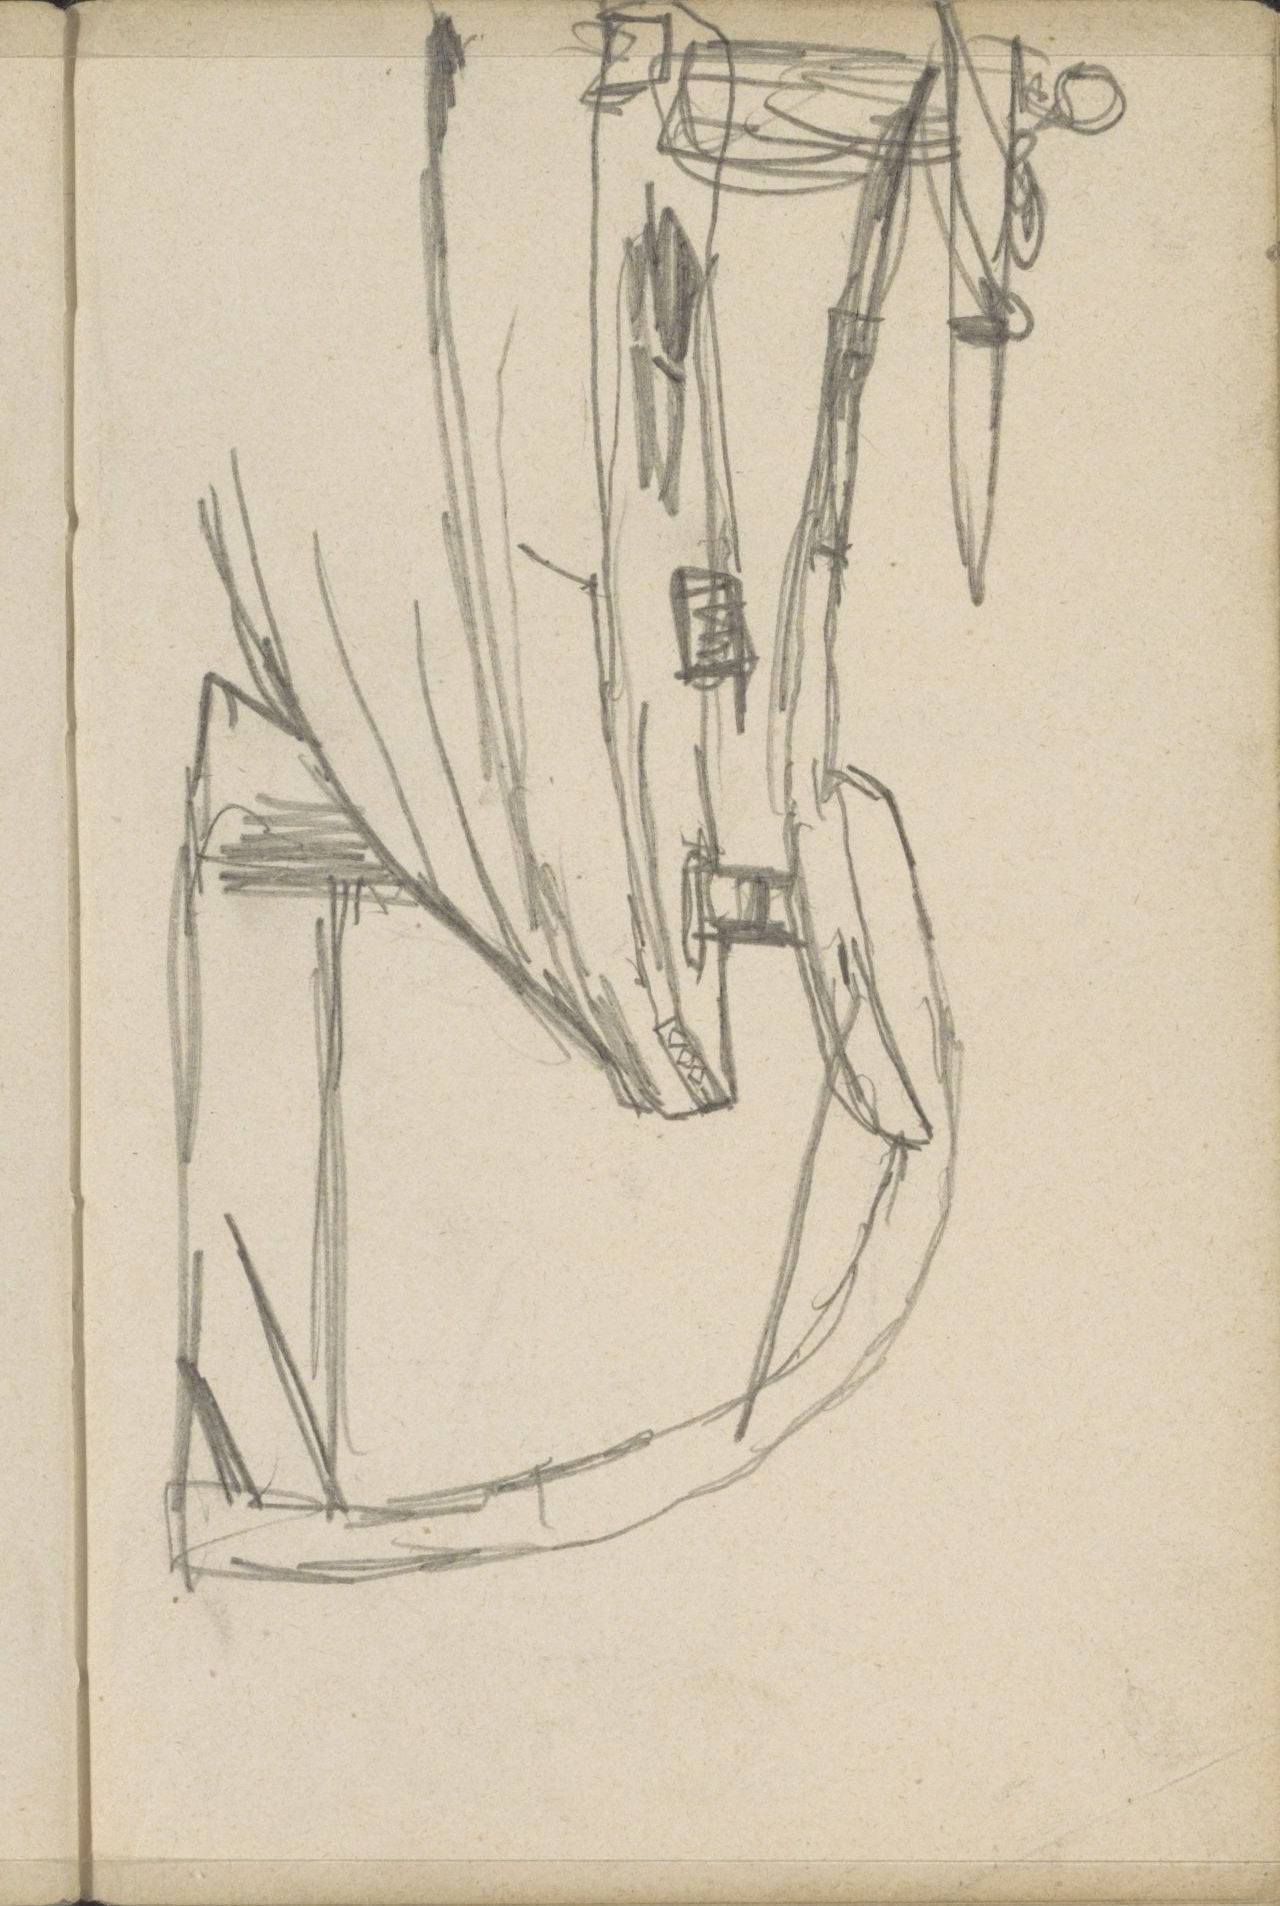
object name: sketchbook leaf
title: Figuur op een boot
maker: george hendrik breitner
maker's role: draughtsman, painter, print maker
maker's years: 1857-1923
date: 1903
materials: paper, pencil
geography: amsterdam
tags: ships (in general)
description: Figuur op een boot. Pagina 68 uit een schetsboek met 46 bladen.